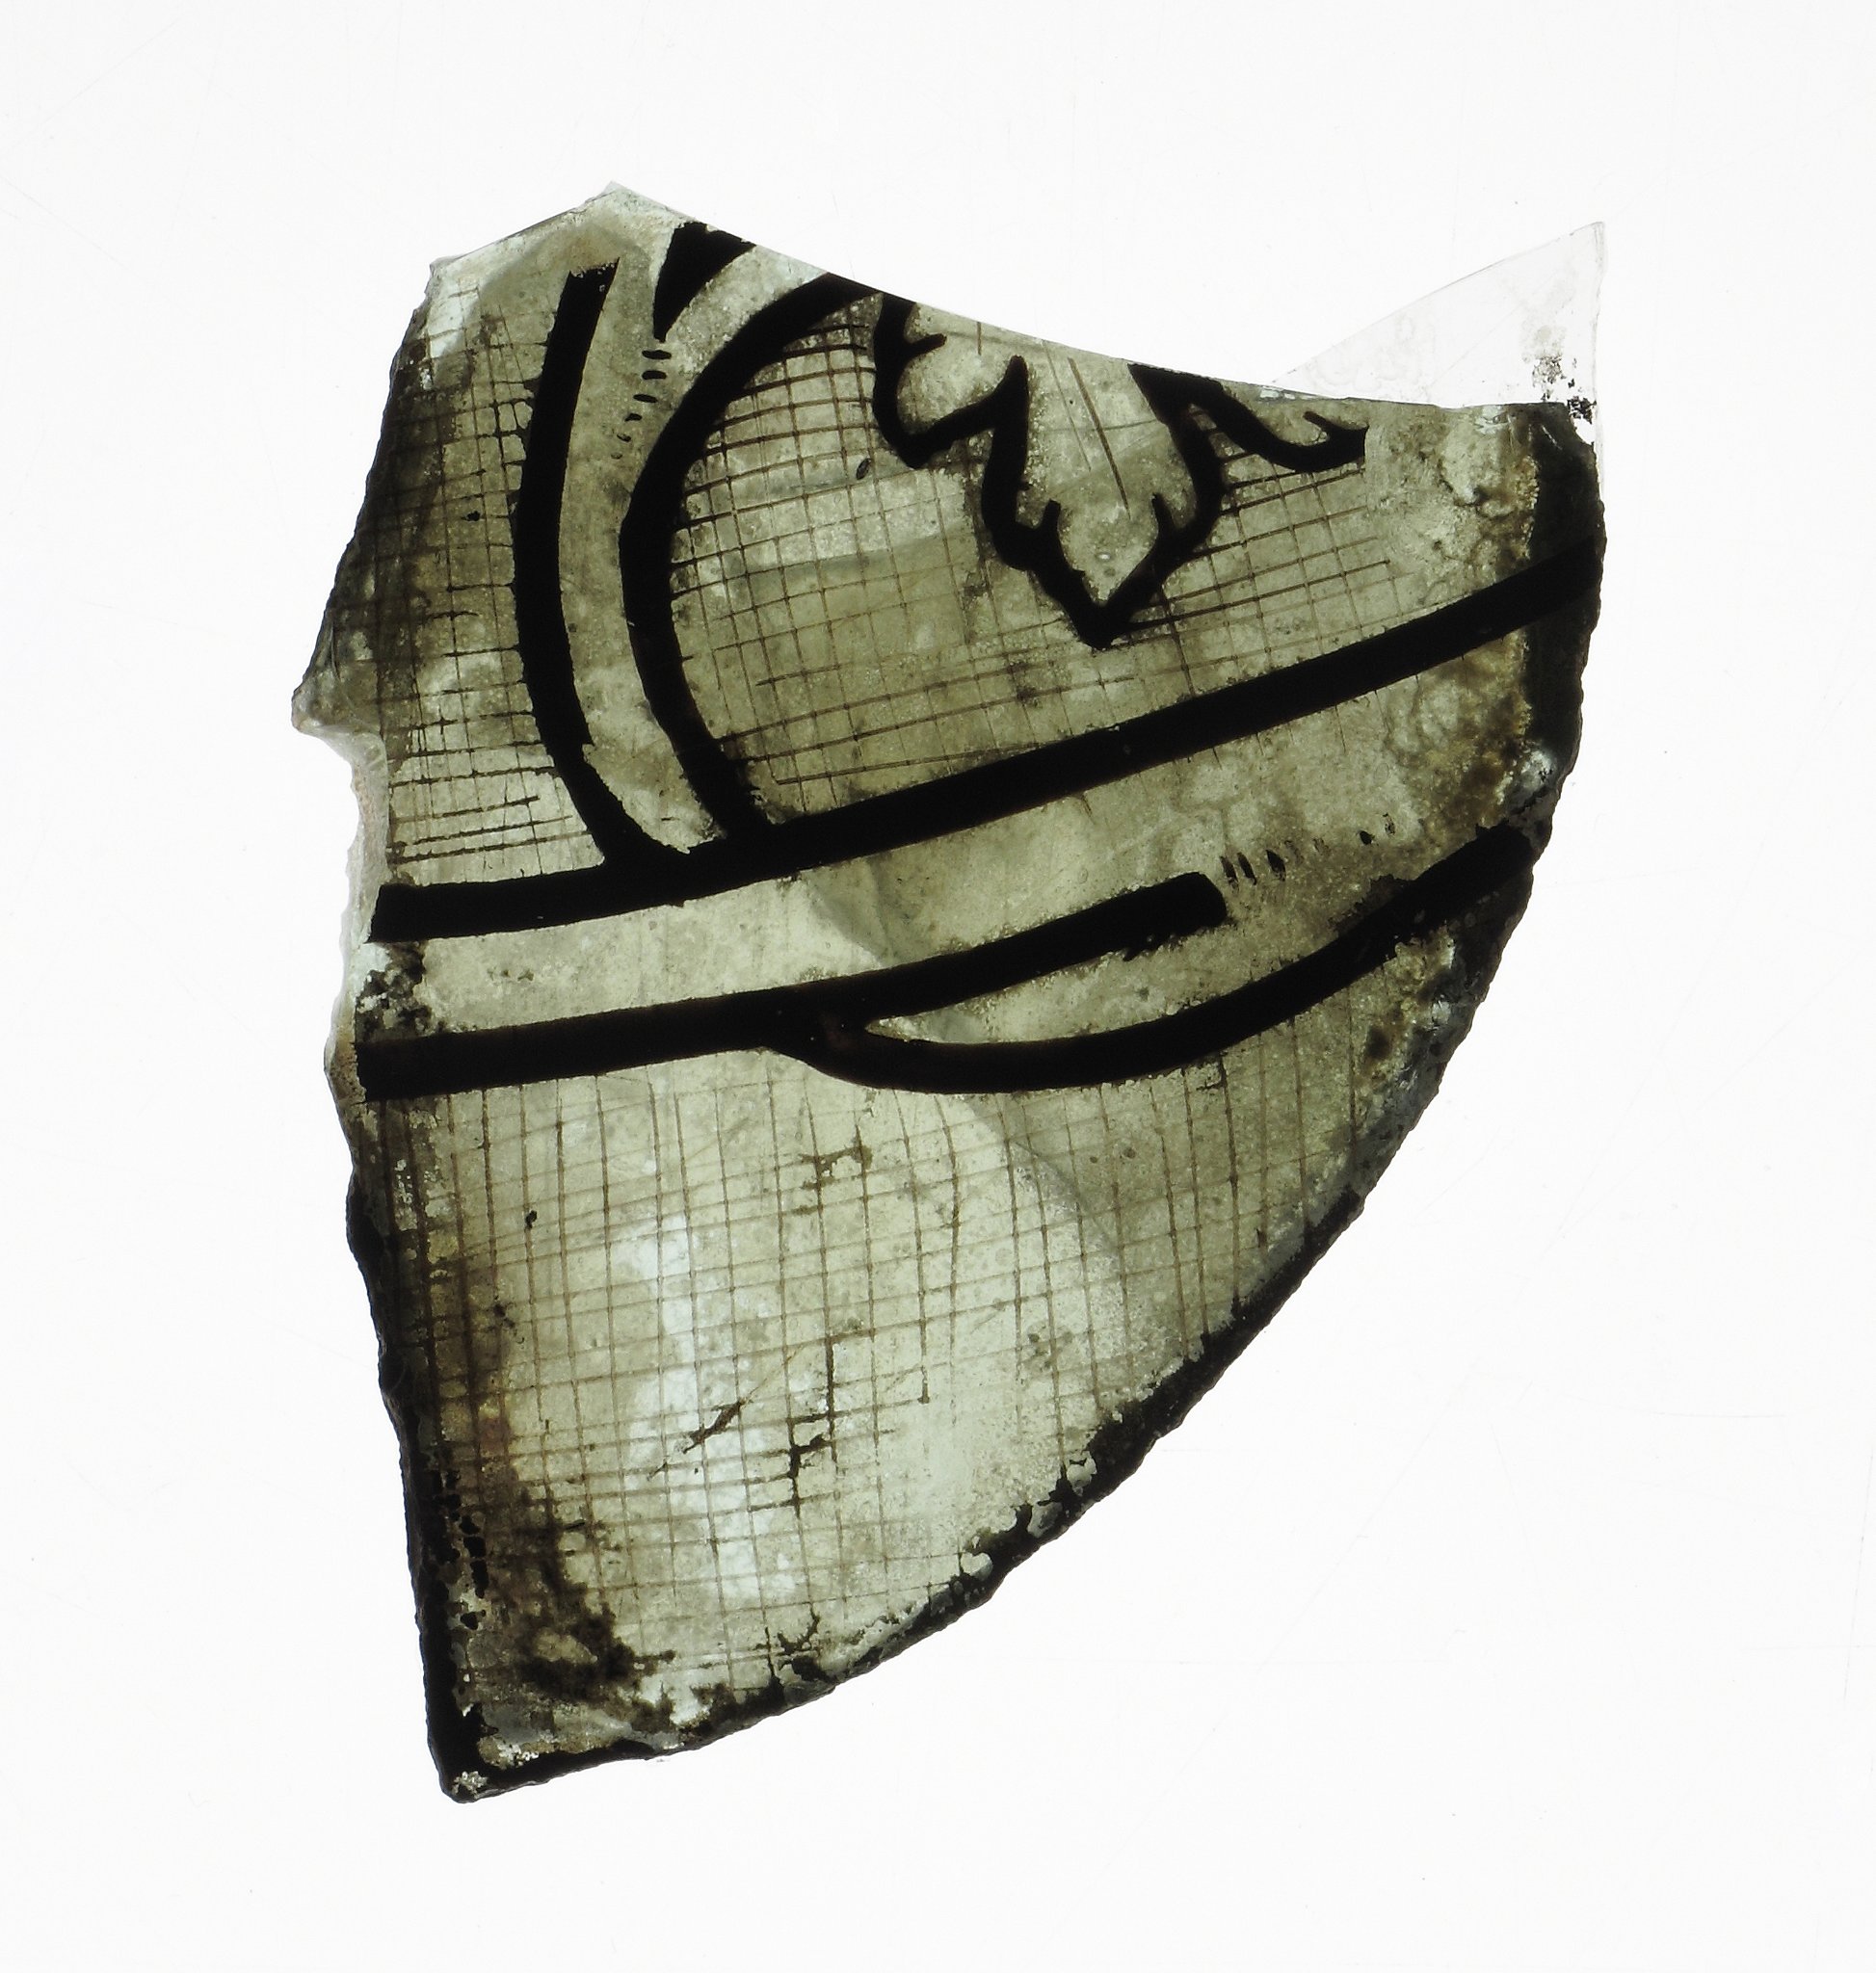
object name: fragment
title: Glass Fragment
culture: french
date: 1301-1400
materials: glass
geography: france